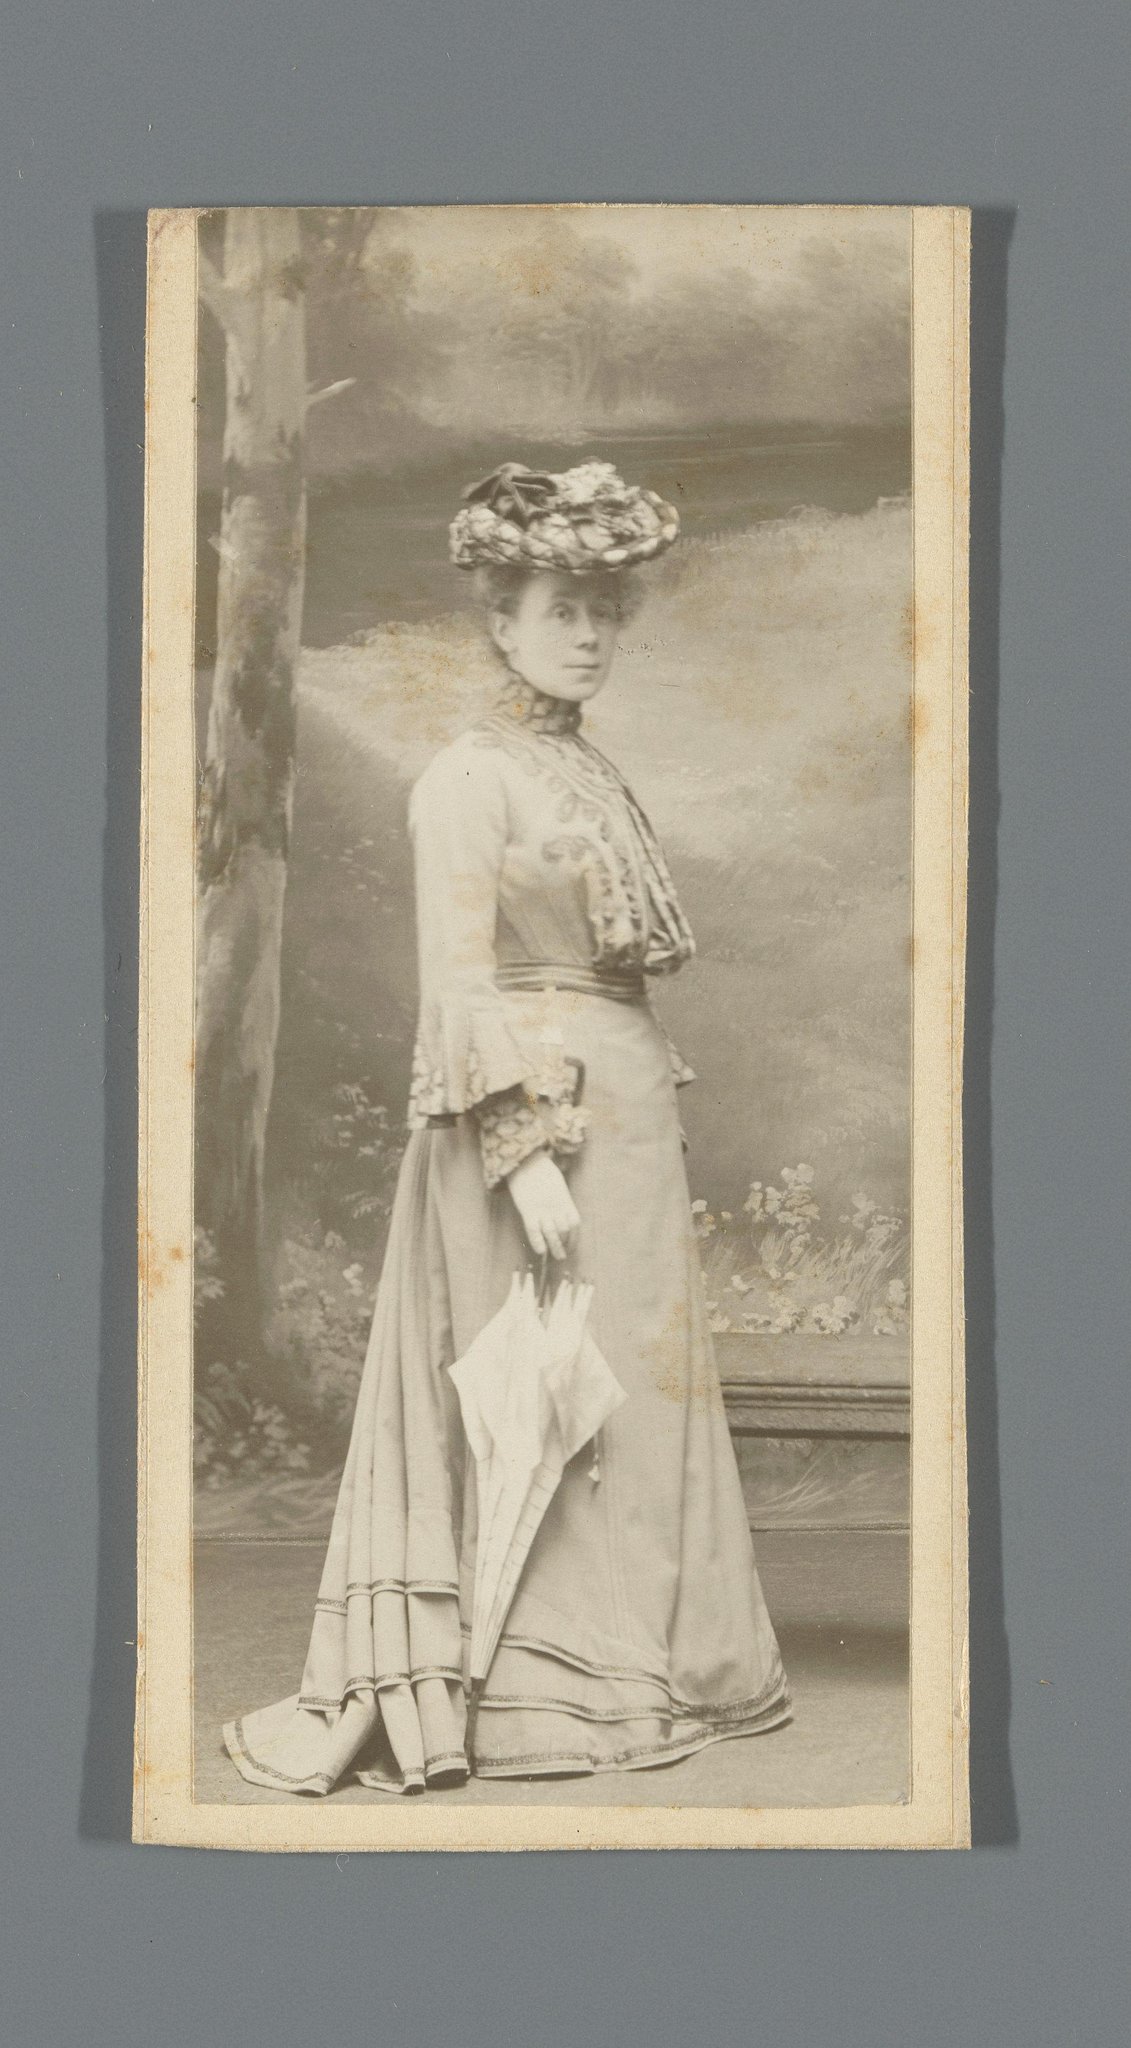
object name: photograph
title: Portret van een onbekende vrouw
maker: Anonymous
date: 1860-1920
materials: cardboard, photographic support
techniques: photography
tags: anonymous historical person portrayed - bb - woman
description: Portret van een onbekende vrouw, staande ten voeten uit. Onderdeel van de collectie foto's van de familie Teding van Berkhout.